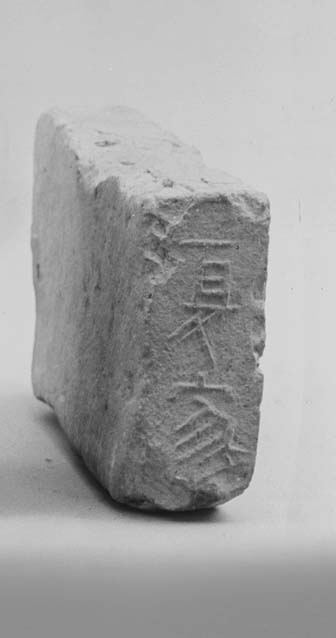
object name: tile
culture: chinese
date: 221 BCE-220 CE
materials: earthenware